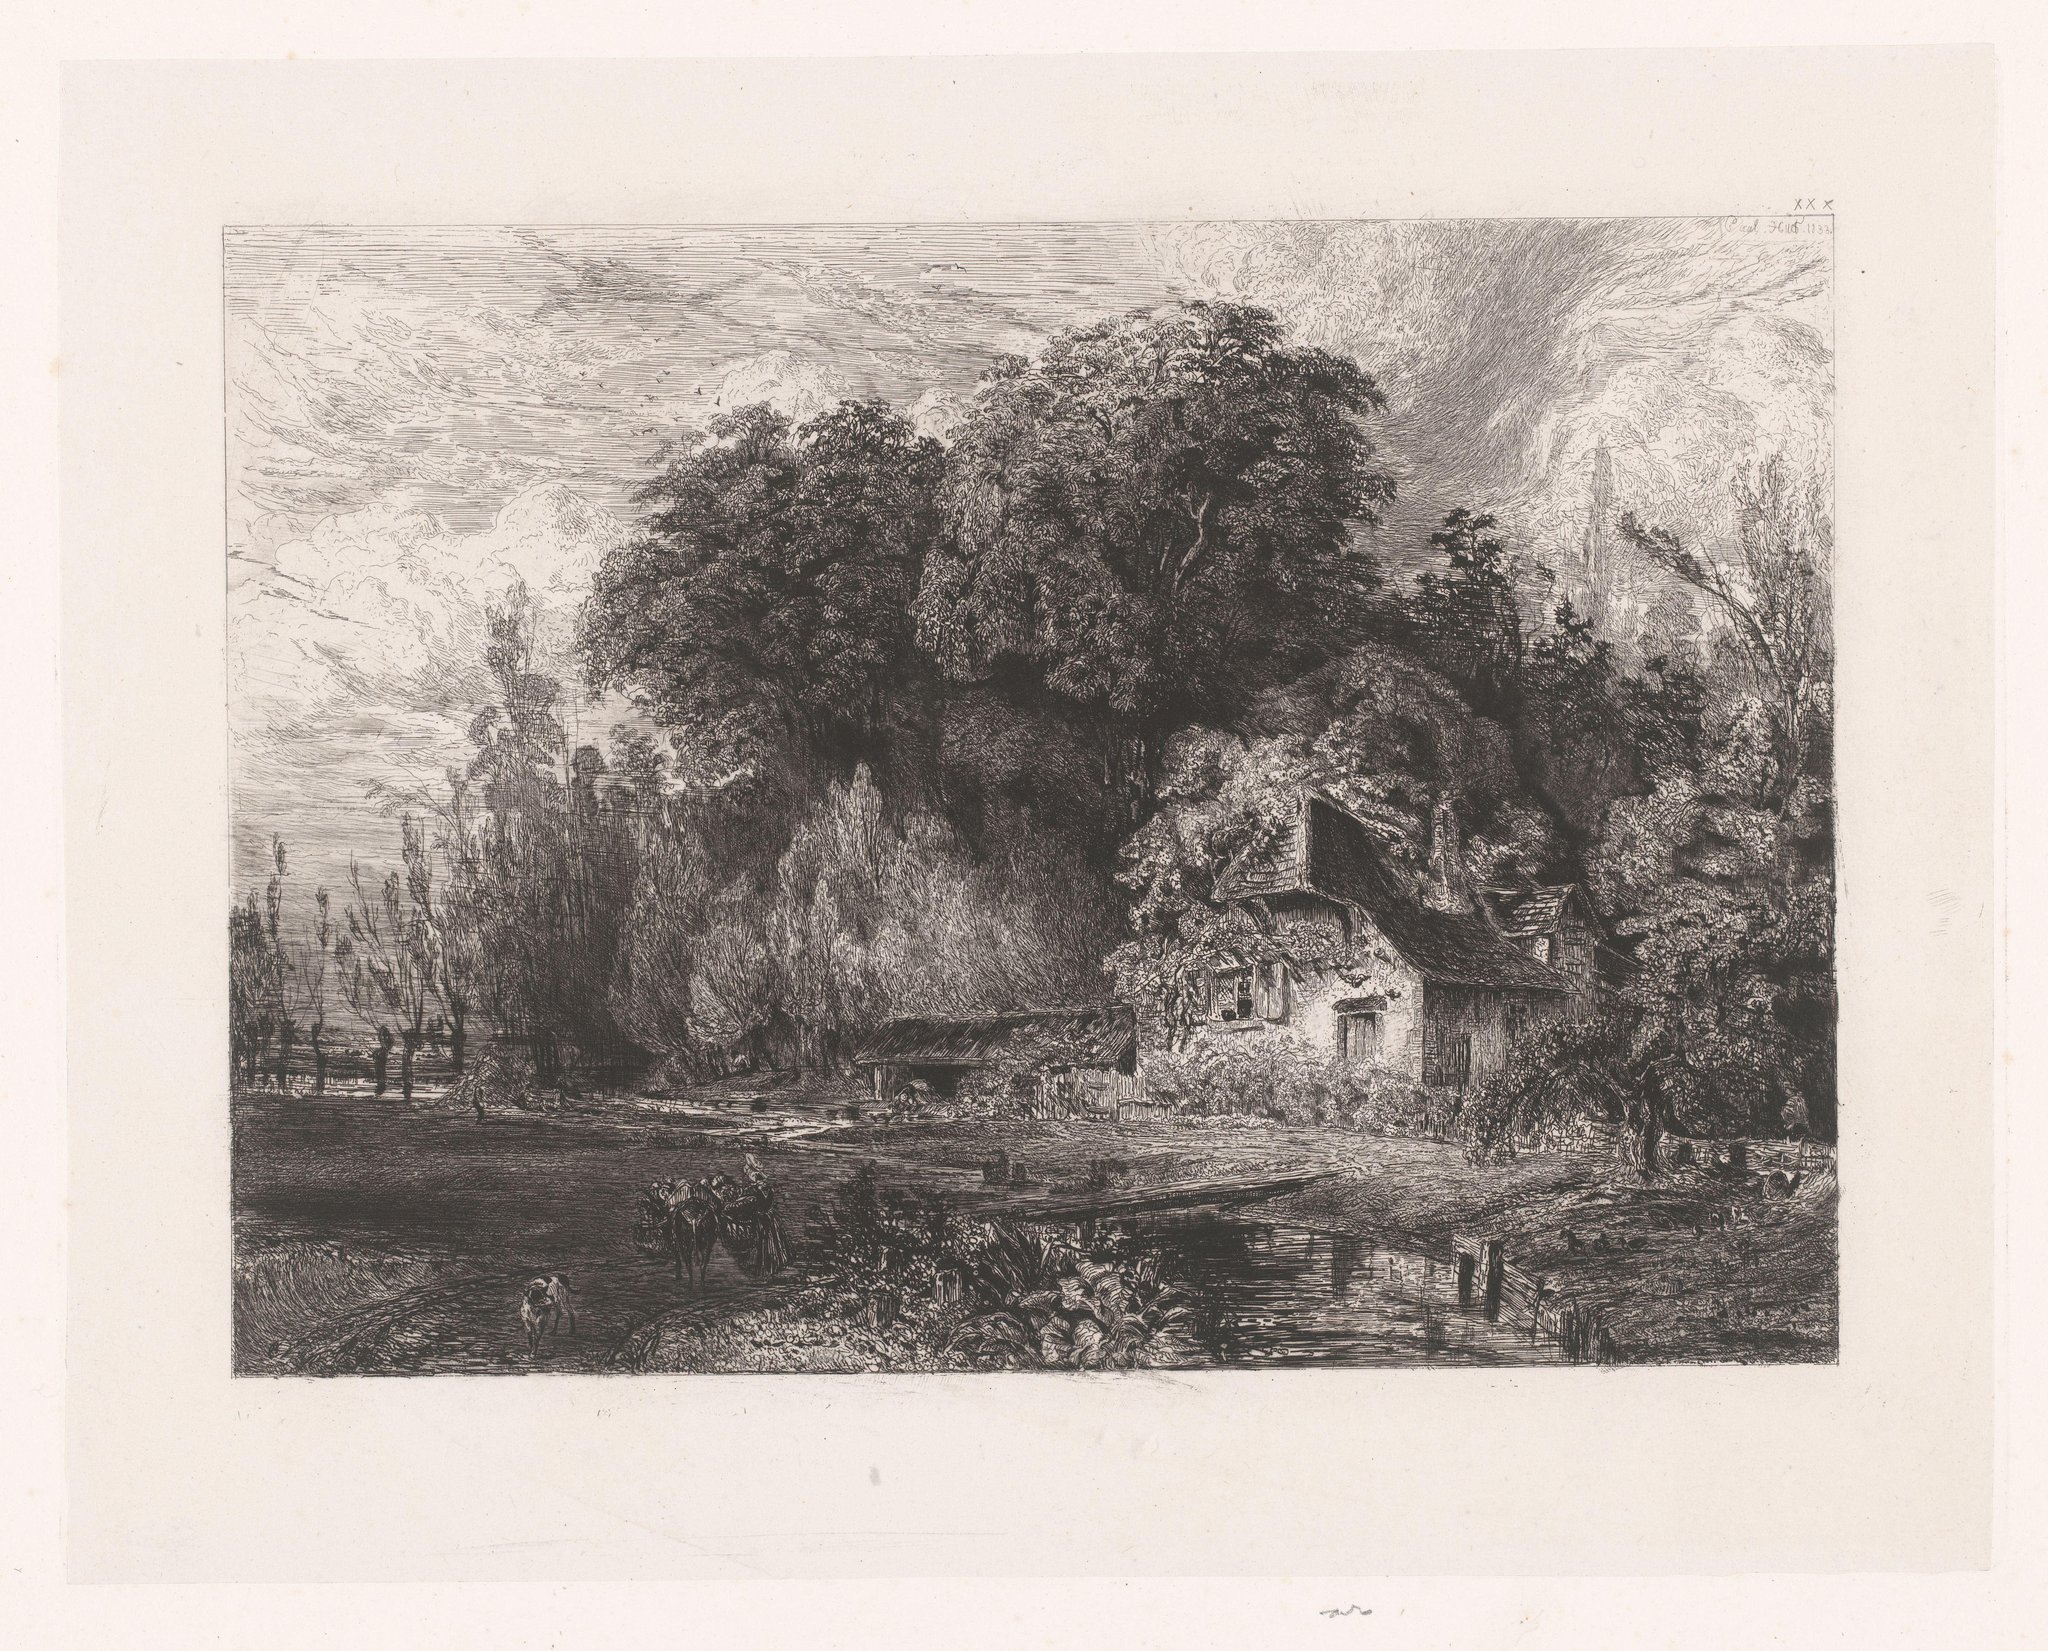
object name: print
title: Gezicht op een huis aan de rand van een bos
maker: paul huet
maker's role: draughtsman, print maker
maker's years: 1803-1869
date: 1833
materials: paper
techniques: etching, roulette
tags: fringe, edge of the wood, cottage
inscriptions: collector's mark: Lugt 2228